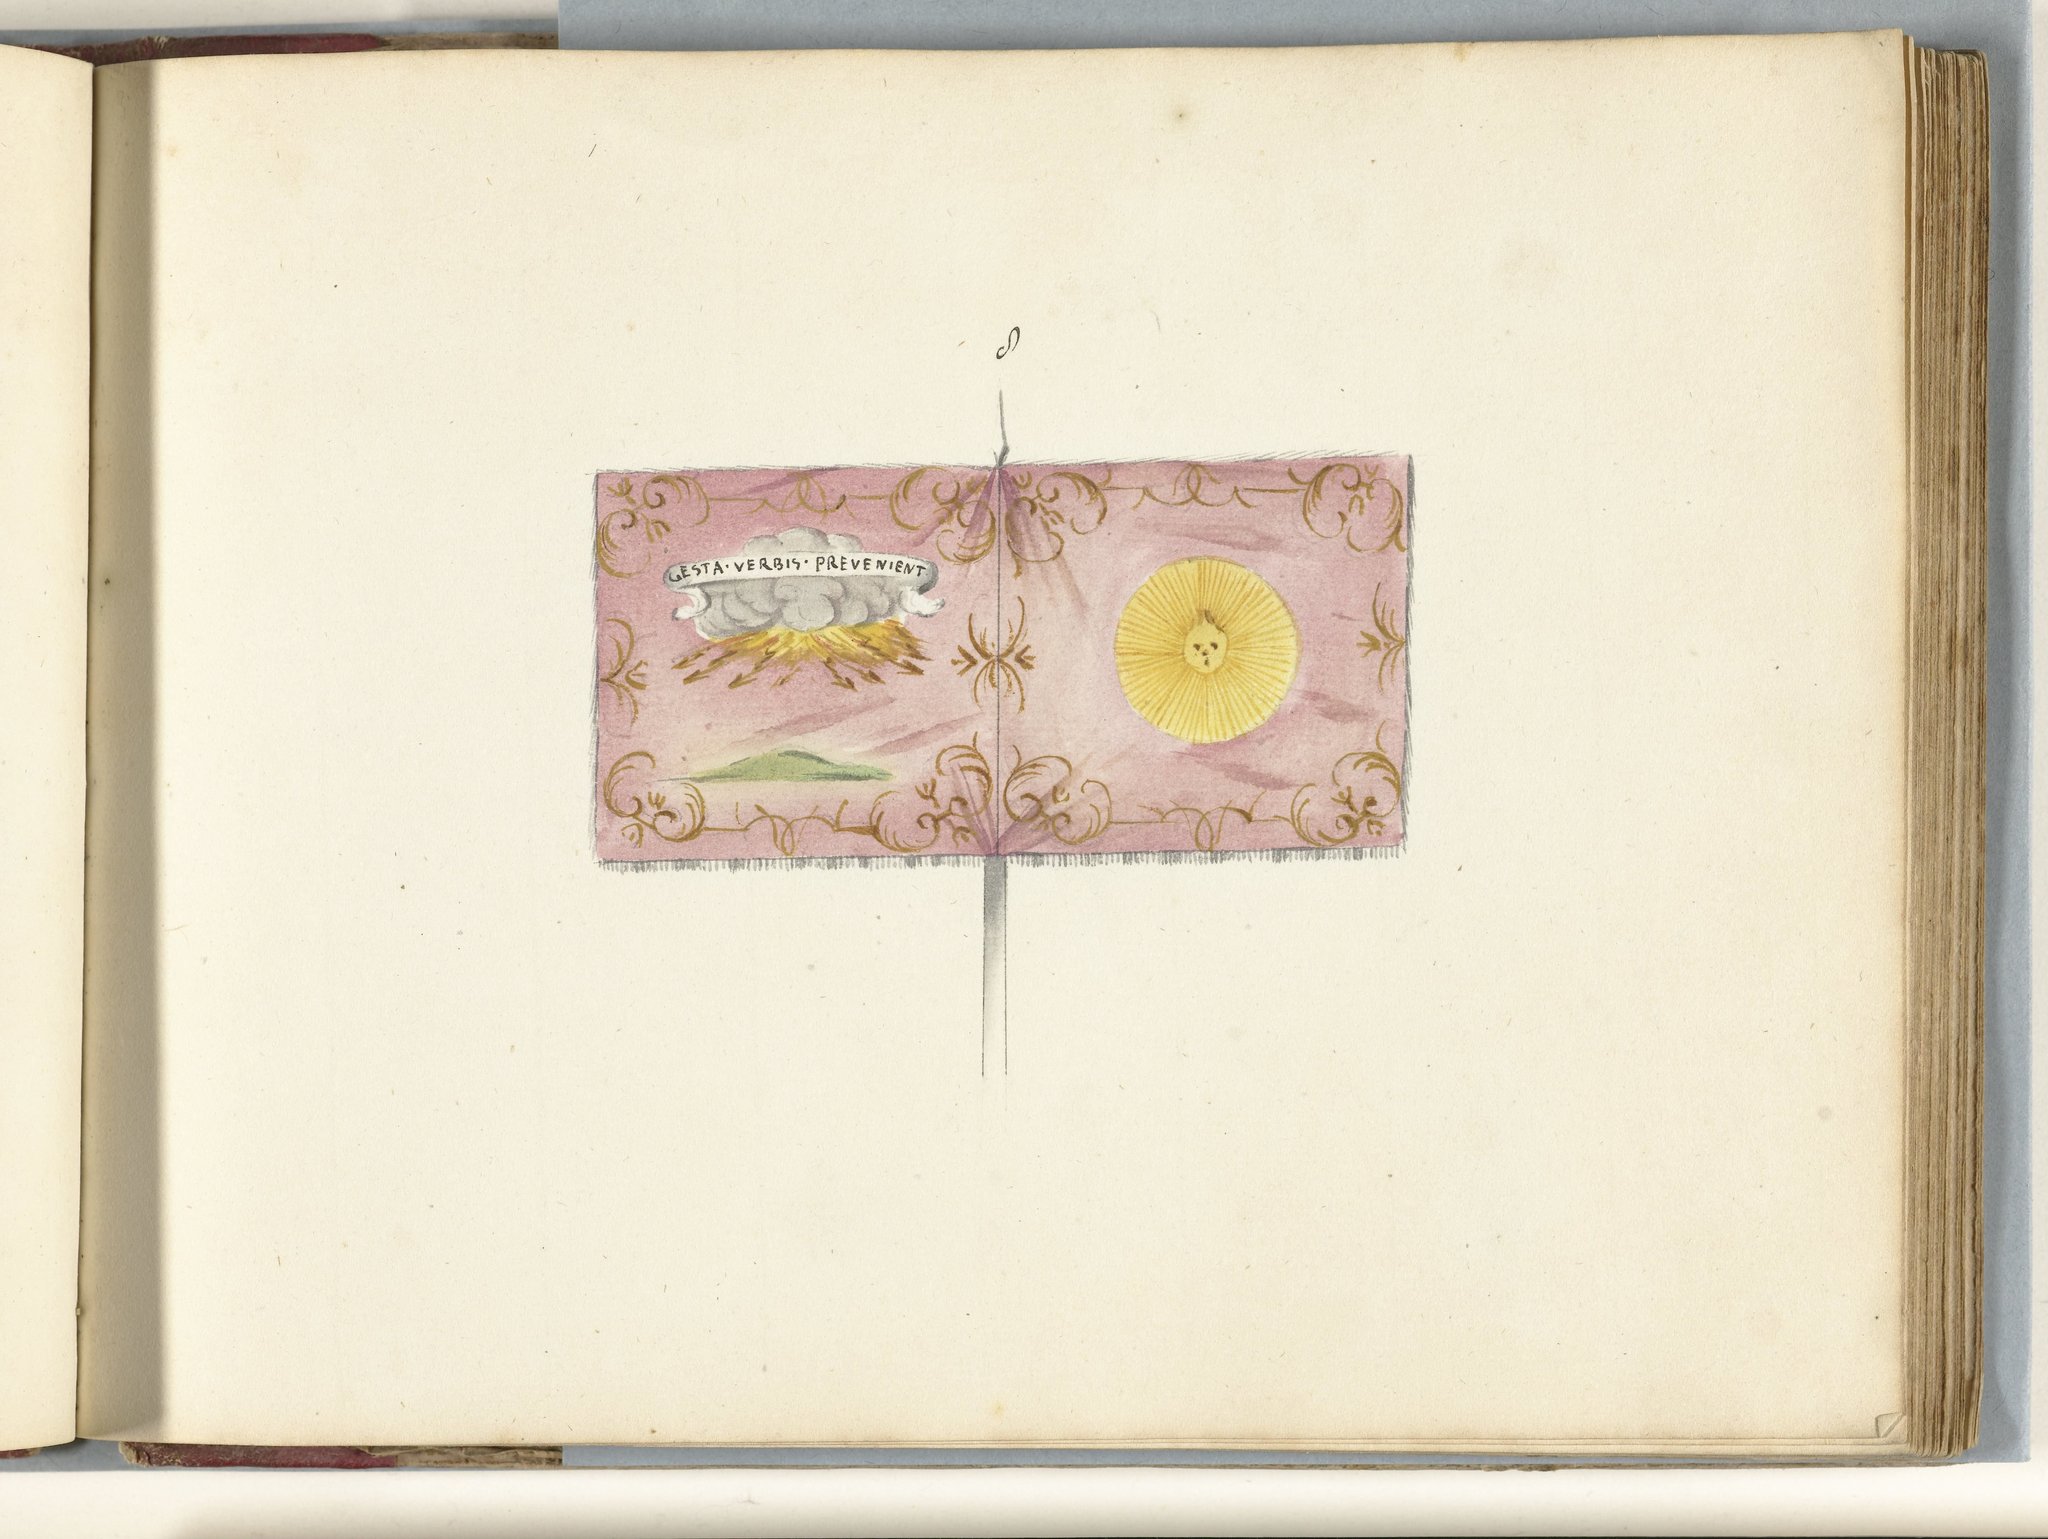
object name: drawing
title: Frans standaard, veroverd in de slag bij Oudenaarde, 1708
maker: Anonymous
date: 1713-1720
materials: paper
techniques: drawing, writing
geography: northern netherlands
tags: (military) flags and standards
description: Een Frans standaard, veroverd bij de slag bij Oudenaarde in 1708. In het boek met tekeningen van Franse vaandels, standaarden en pauken, veroverd tijdens de Spaanse Successieoorlog (1701-1713).